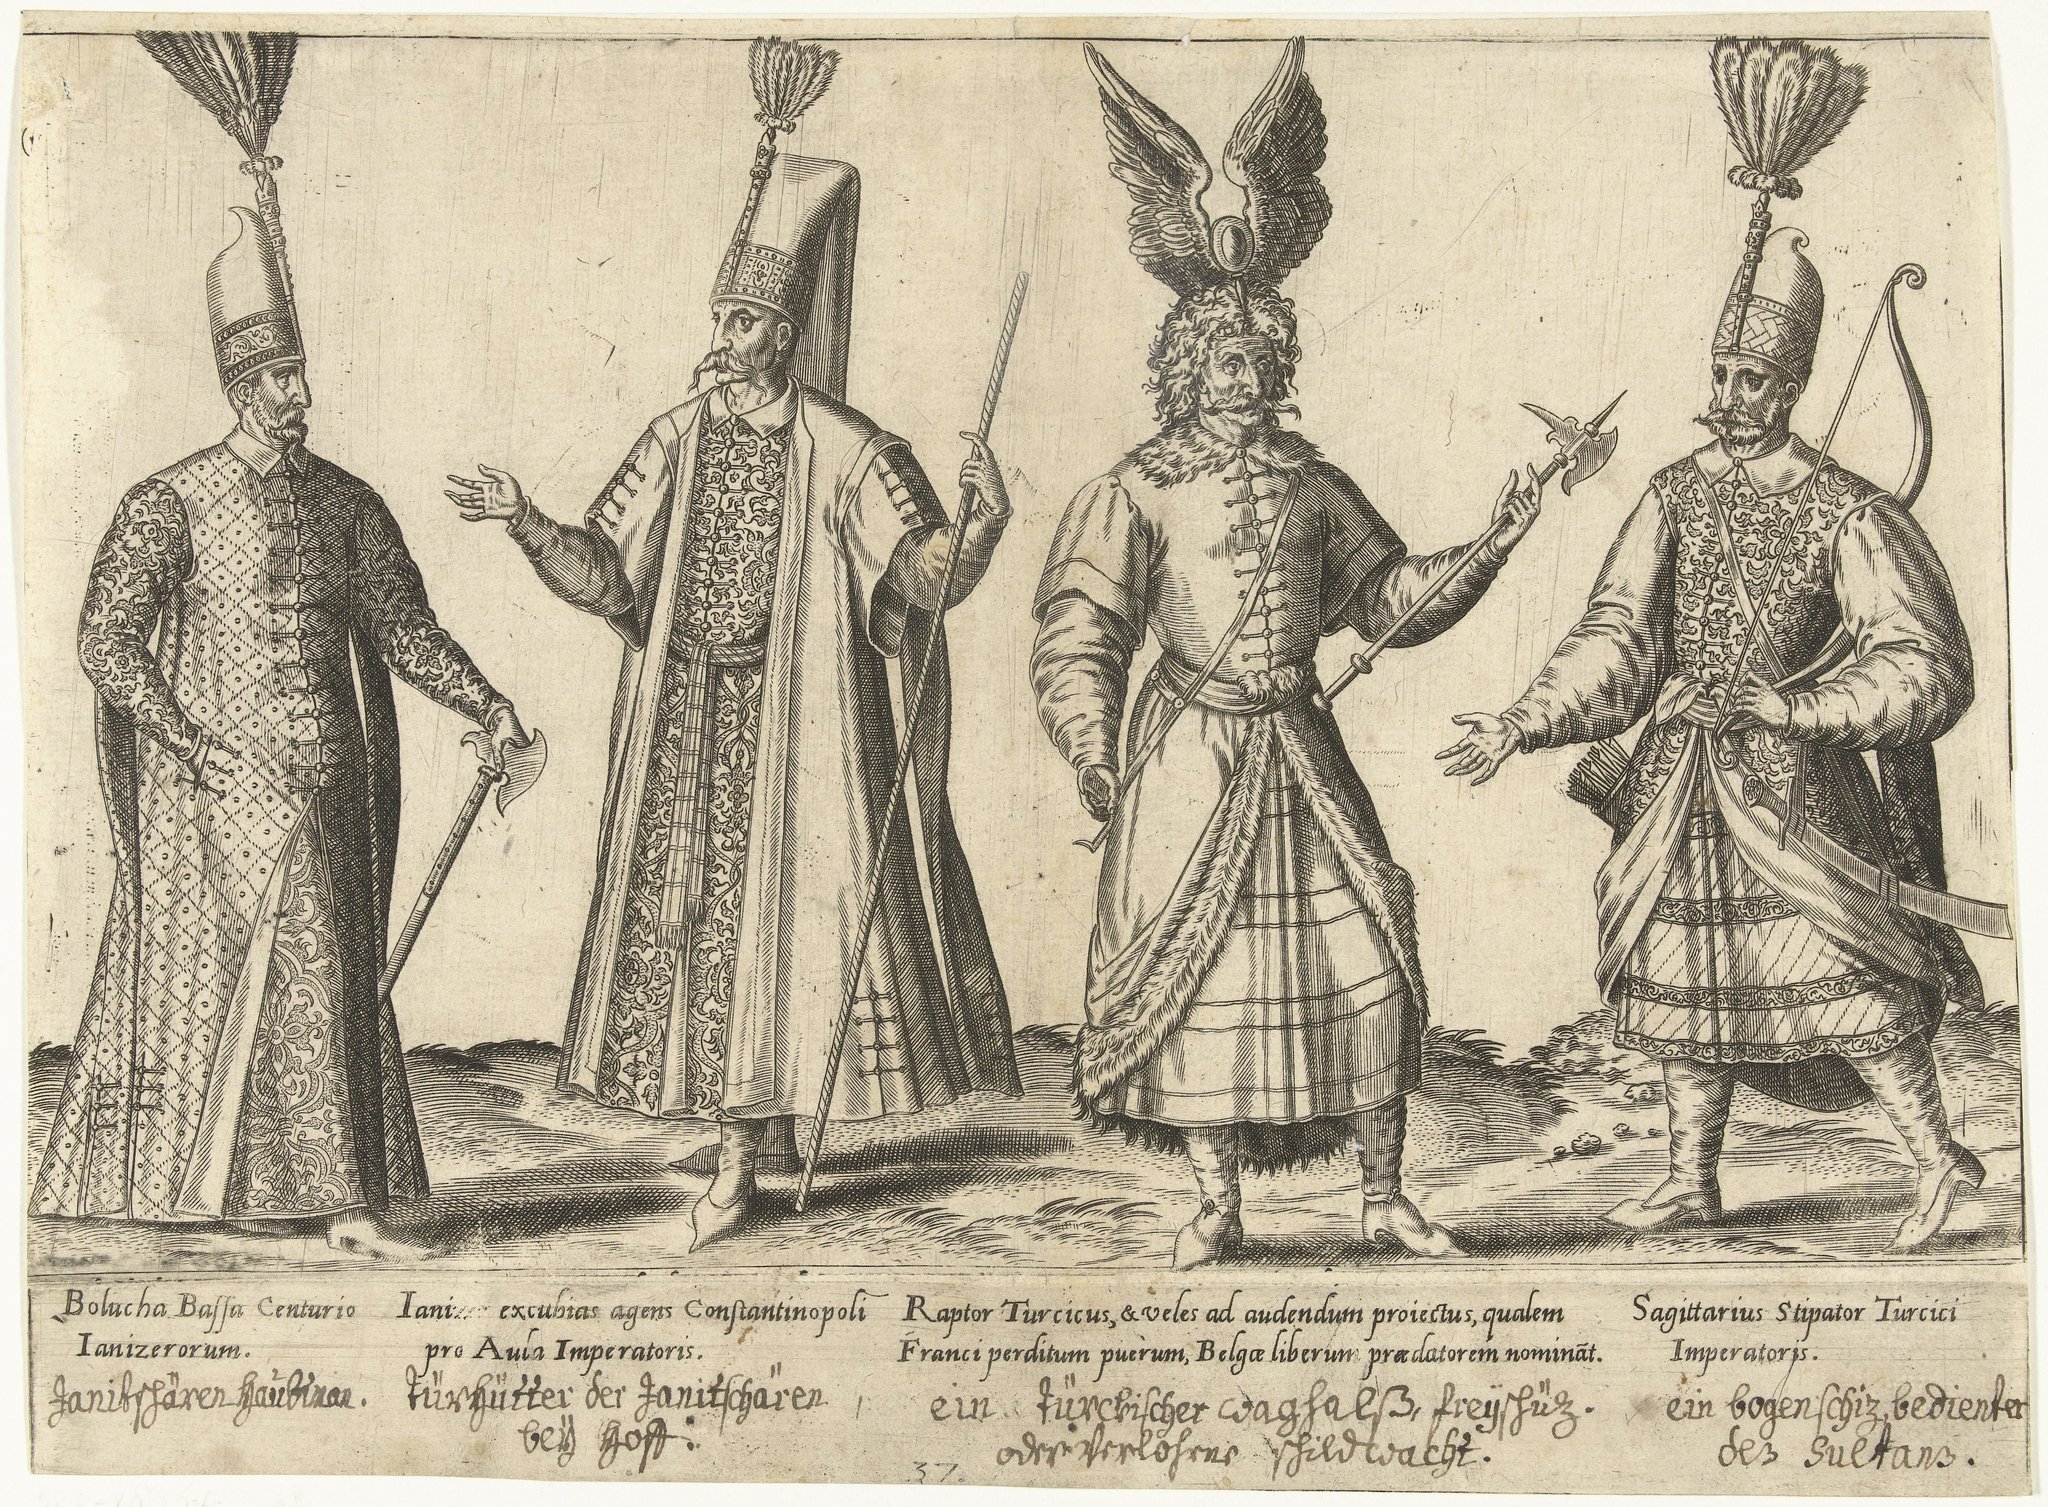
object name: costume print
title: Traditionele kleding van over de hele wereld rond 1580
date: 1581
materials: paper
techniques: engraving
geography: antwerp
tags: asiatic races and peoples: turks, private soldier, commander-in-chief, general, marshal, clothes, costume (+ men's clothes), officer, shooting with bow and arrow, archery (~ games of skill)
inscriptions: caption: ‘Janissären ...Türhütter der Janischären...ein Türchicher waghalB freijrfüz...ein bogenschiz bediender des Sultans’, collector's mark: Lugt 2228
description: Prent uit een boek over zestiende-eeuwse kleding rond 1580. Vier soldaten uit het Ottomaanse leger. Alle vier zijn anders gekleed. Van links naar rechts: een janitsaarse officier (elitesoldaat) met een bijl, een janitsaarse generaal met een staf, een buitenlandse schildwacht met een bijl en een zwaard en een boogschutter in dienst van de sultan. De prent heeft een Latijns onderschrift.